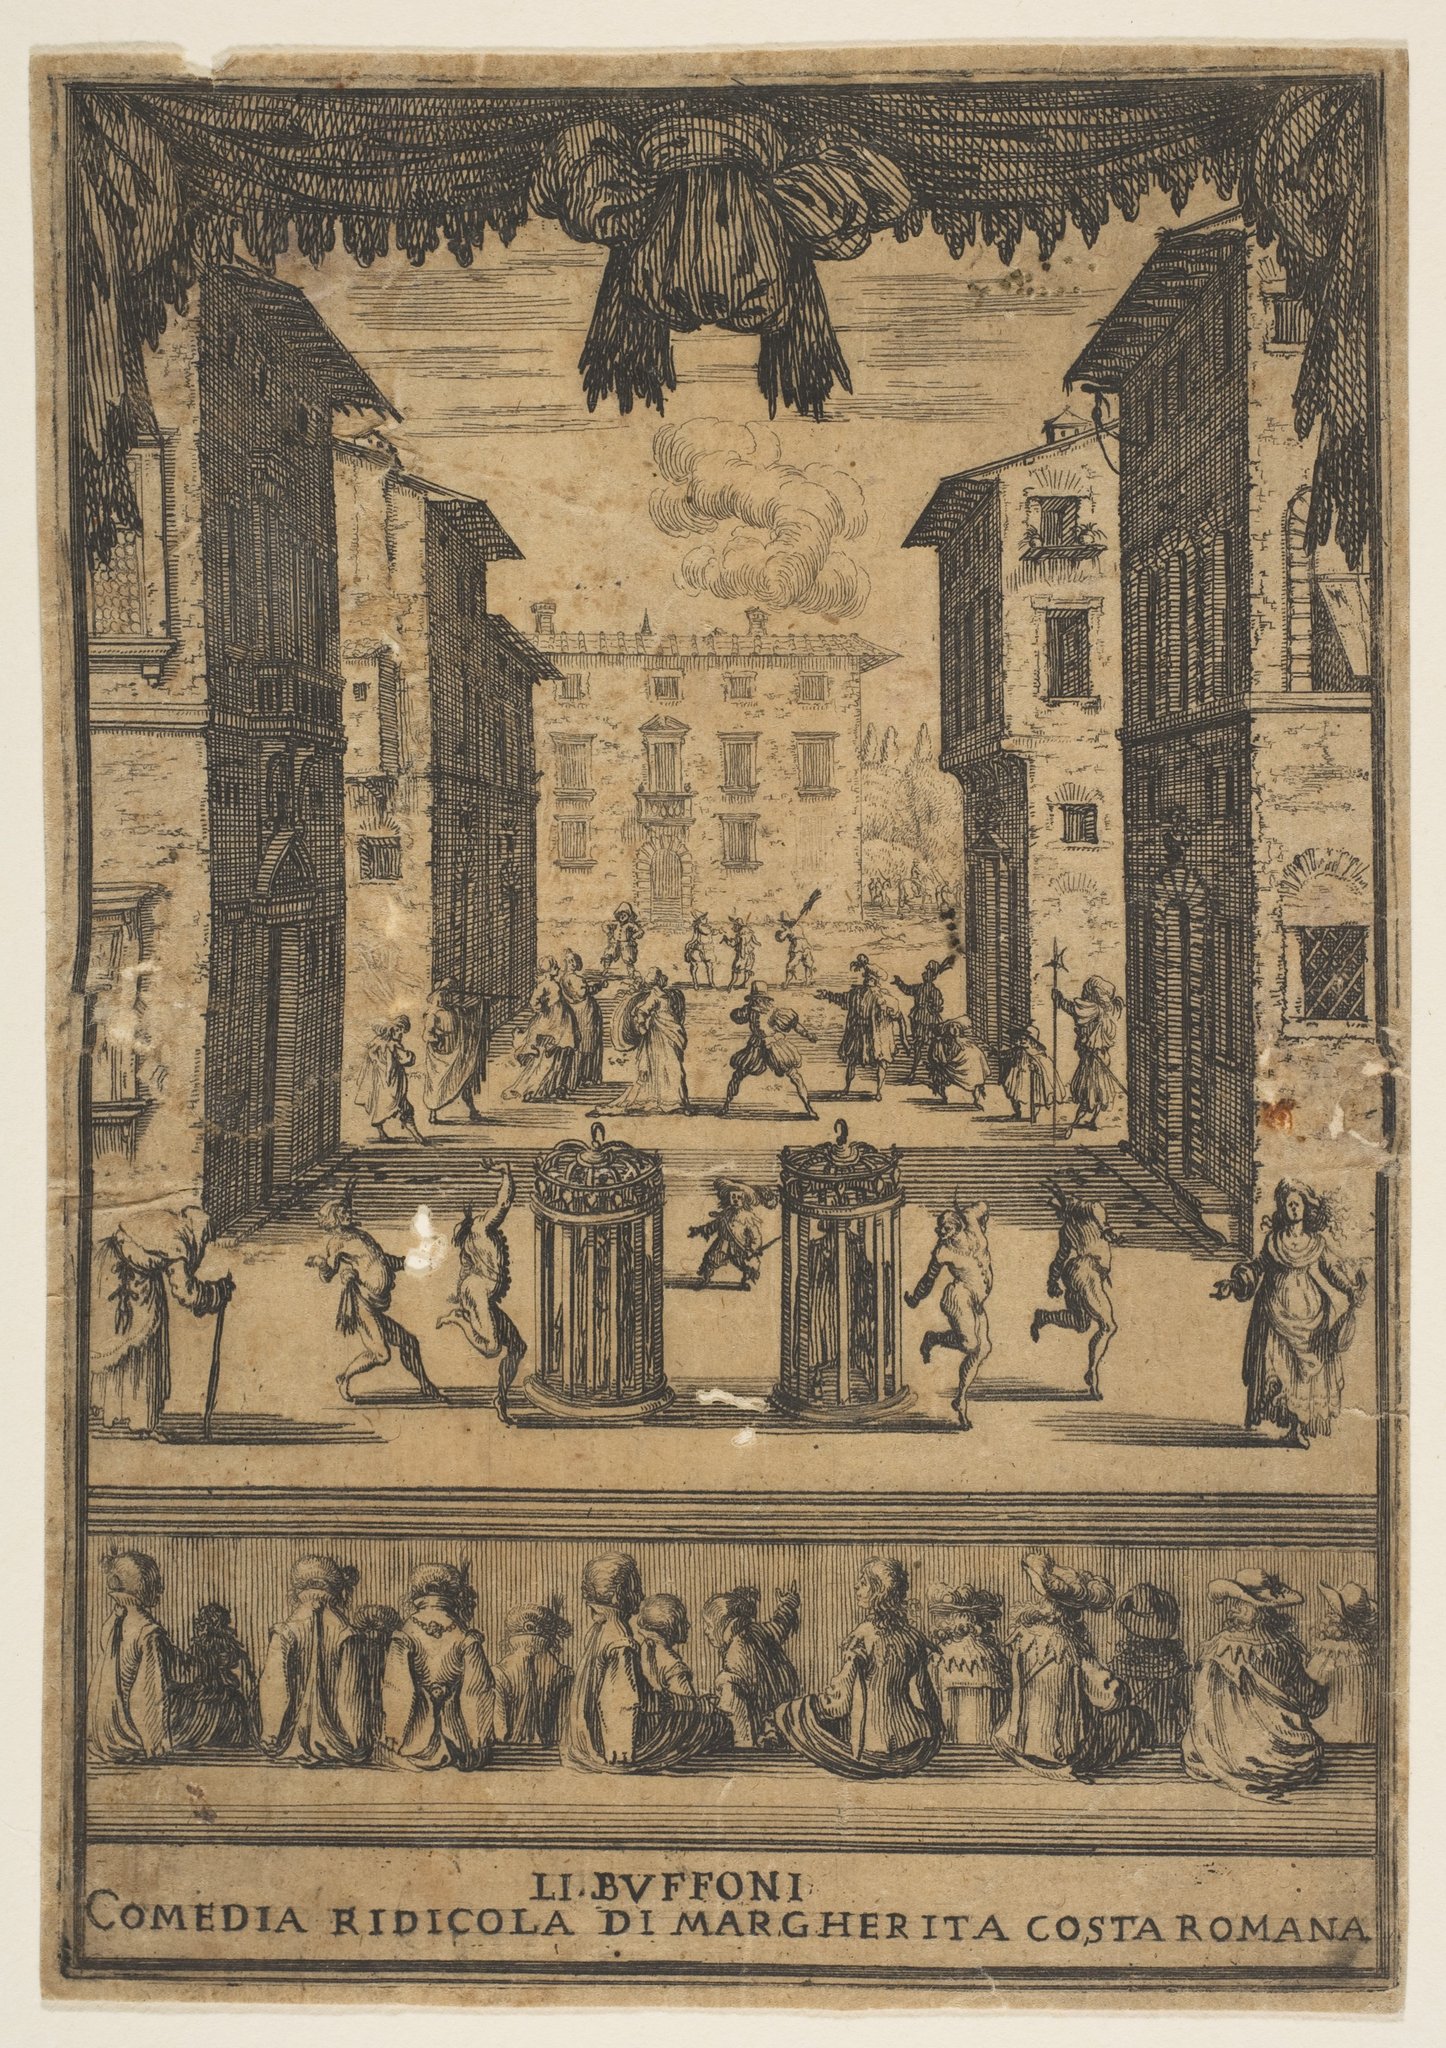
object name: print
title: Frontispiece for the comedy "The Buffoons" (Li Buffoni)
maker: stefano della bella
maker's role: artist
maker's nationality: italian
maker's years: 1610-1664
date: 1639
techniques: etching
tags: buildings,men,women,spectators,dancing